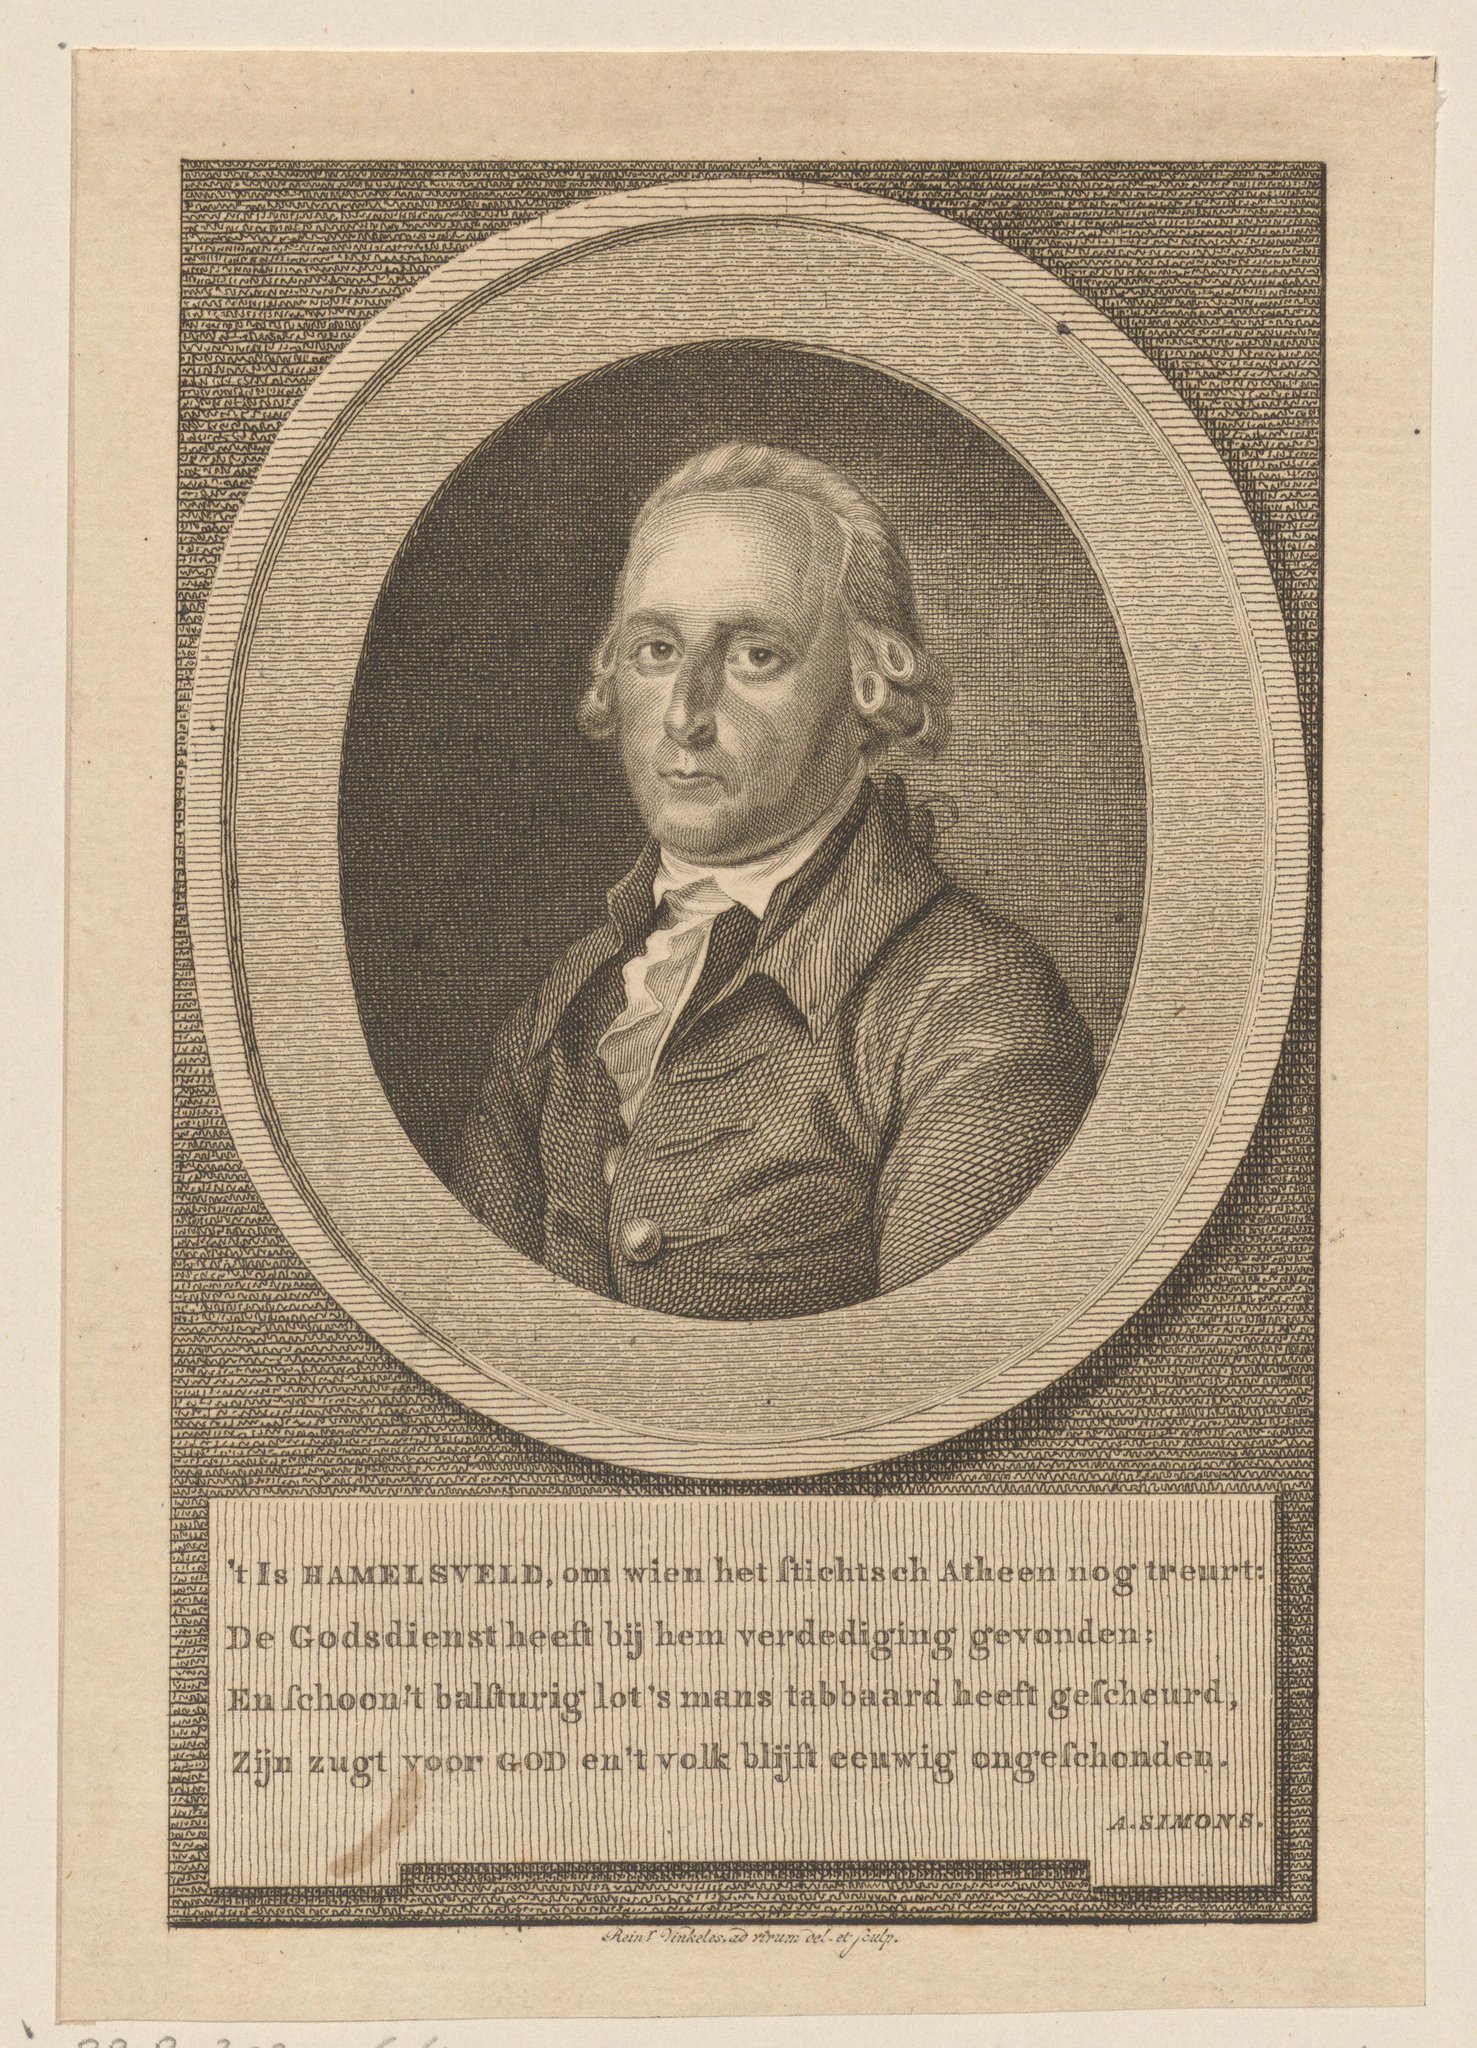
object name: print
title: Portret van IJsbrand van Hamelsveld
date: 1751-1816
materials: paper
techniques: engraving, etching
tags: utrecht, amsterdam, ijsbrand van hamelsveld, historical persons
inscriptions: collector's mark: Lugt 2166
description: Andere staat van deze prent gebruikt in: Loosjes, Petrus. Vaderlandsche historie, (...) ten vervolge van Wagenaars Vaderlandsche historie. Amsterdam: Johannes Allart, 1786-1811, dl. 21.